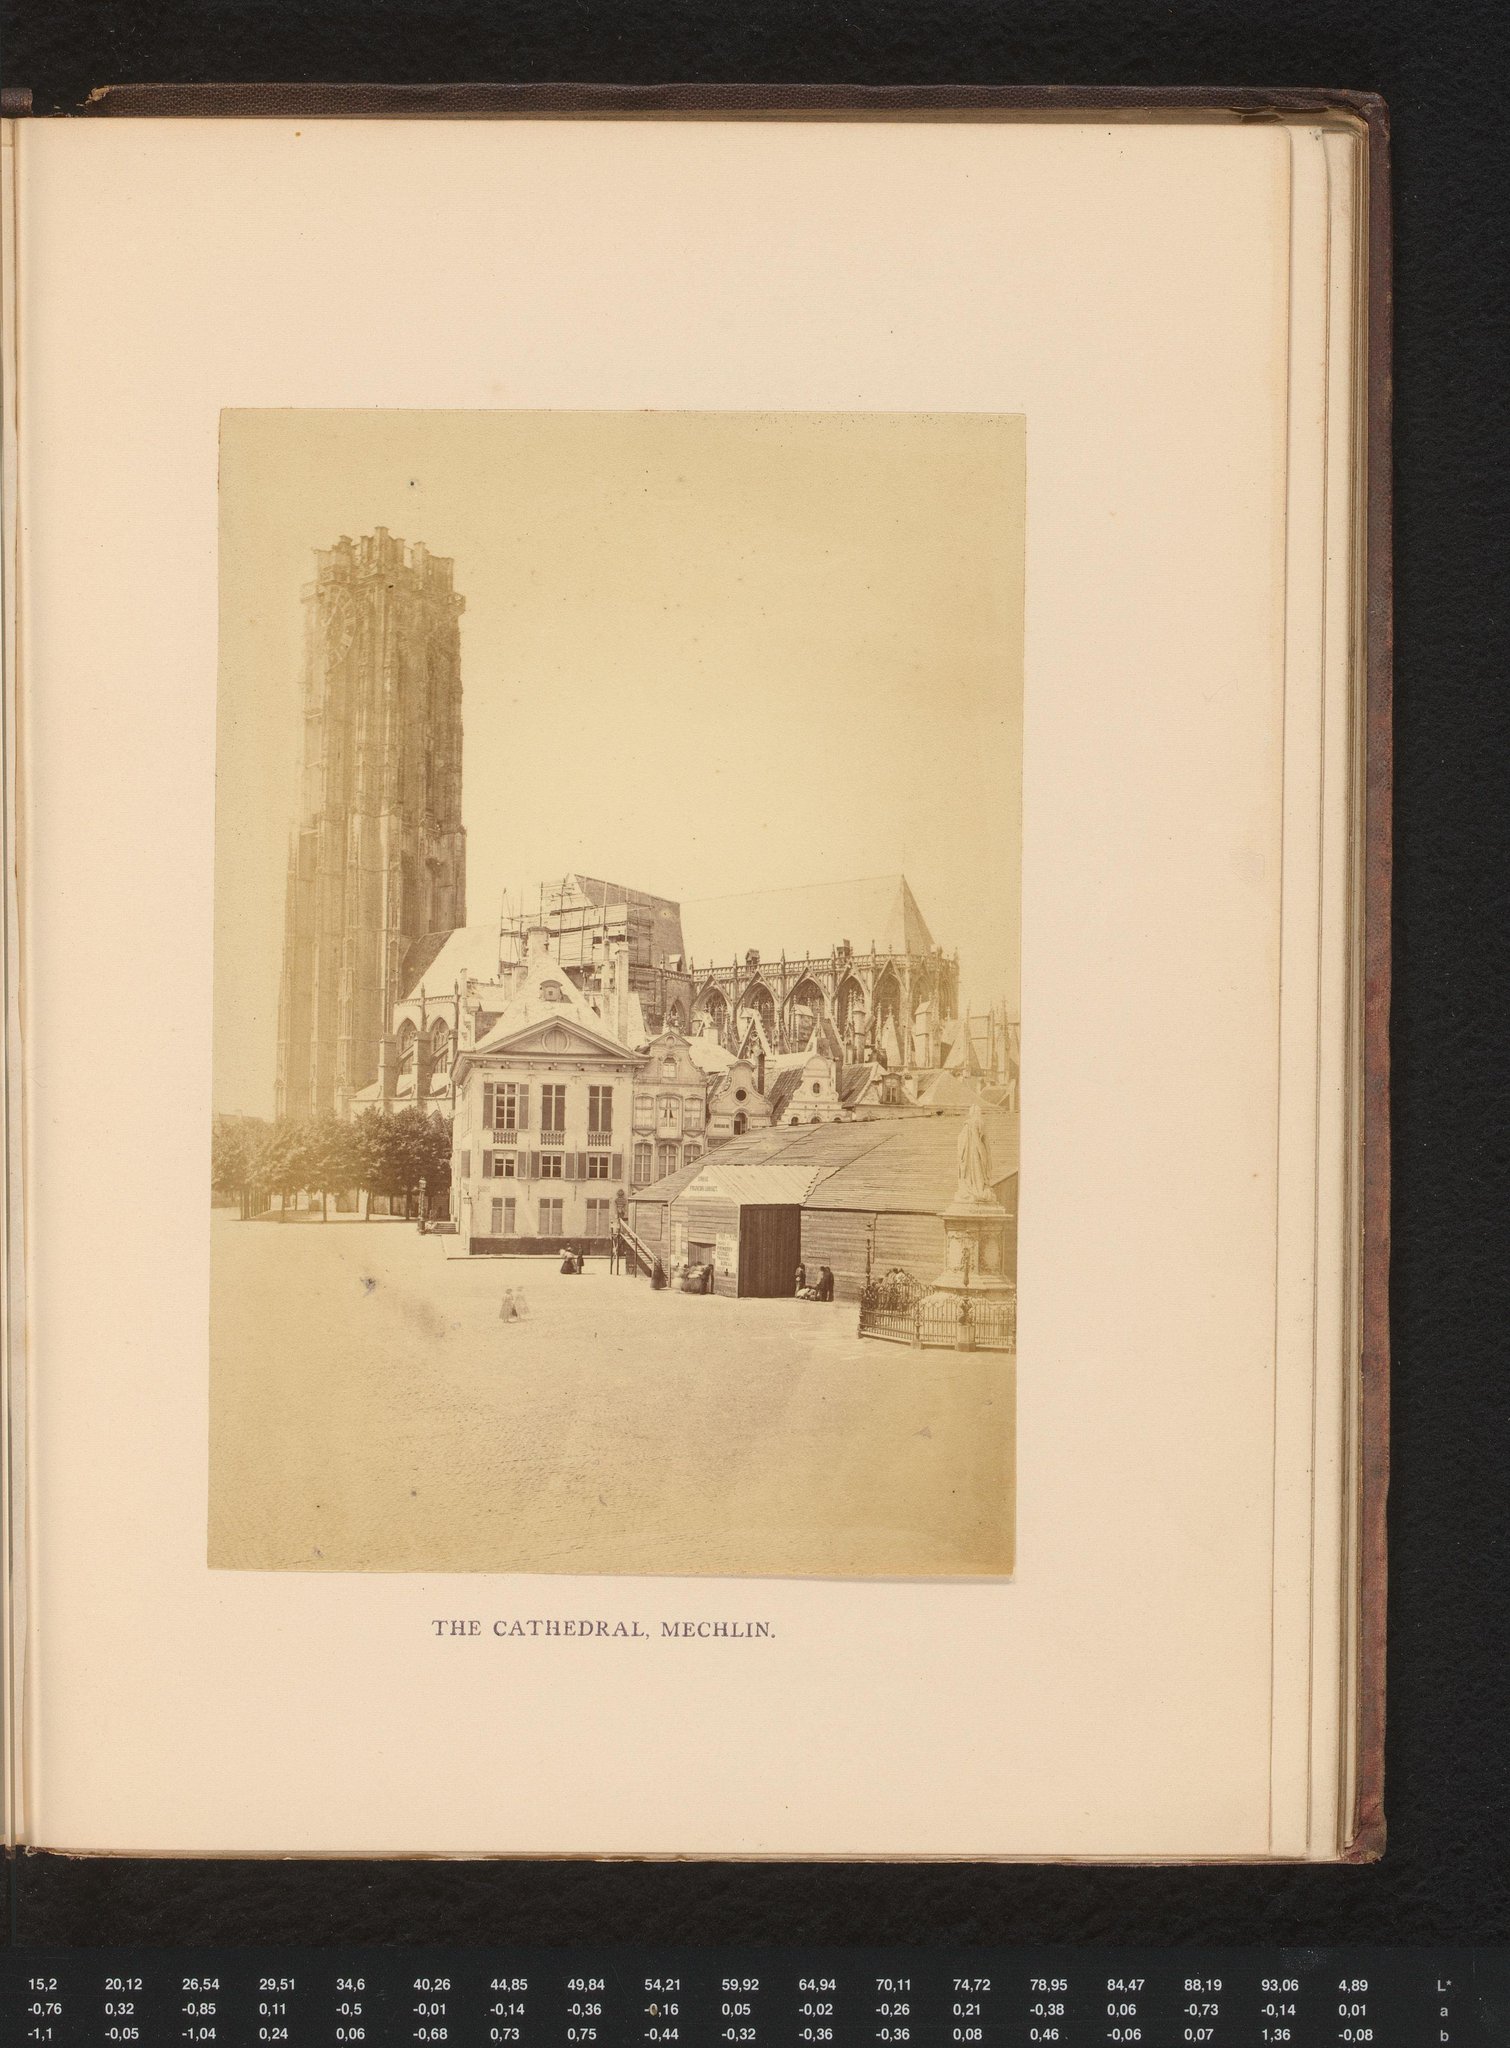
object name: photograph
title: The Cathedral, Mechlin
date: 1855-1866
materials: paper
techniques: albumen print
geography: mechelen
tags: church (exterior)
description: Foto op tweede ongenummerde pagina na pagina 155.